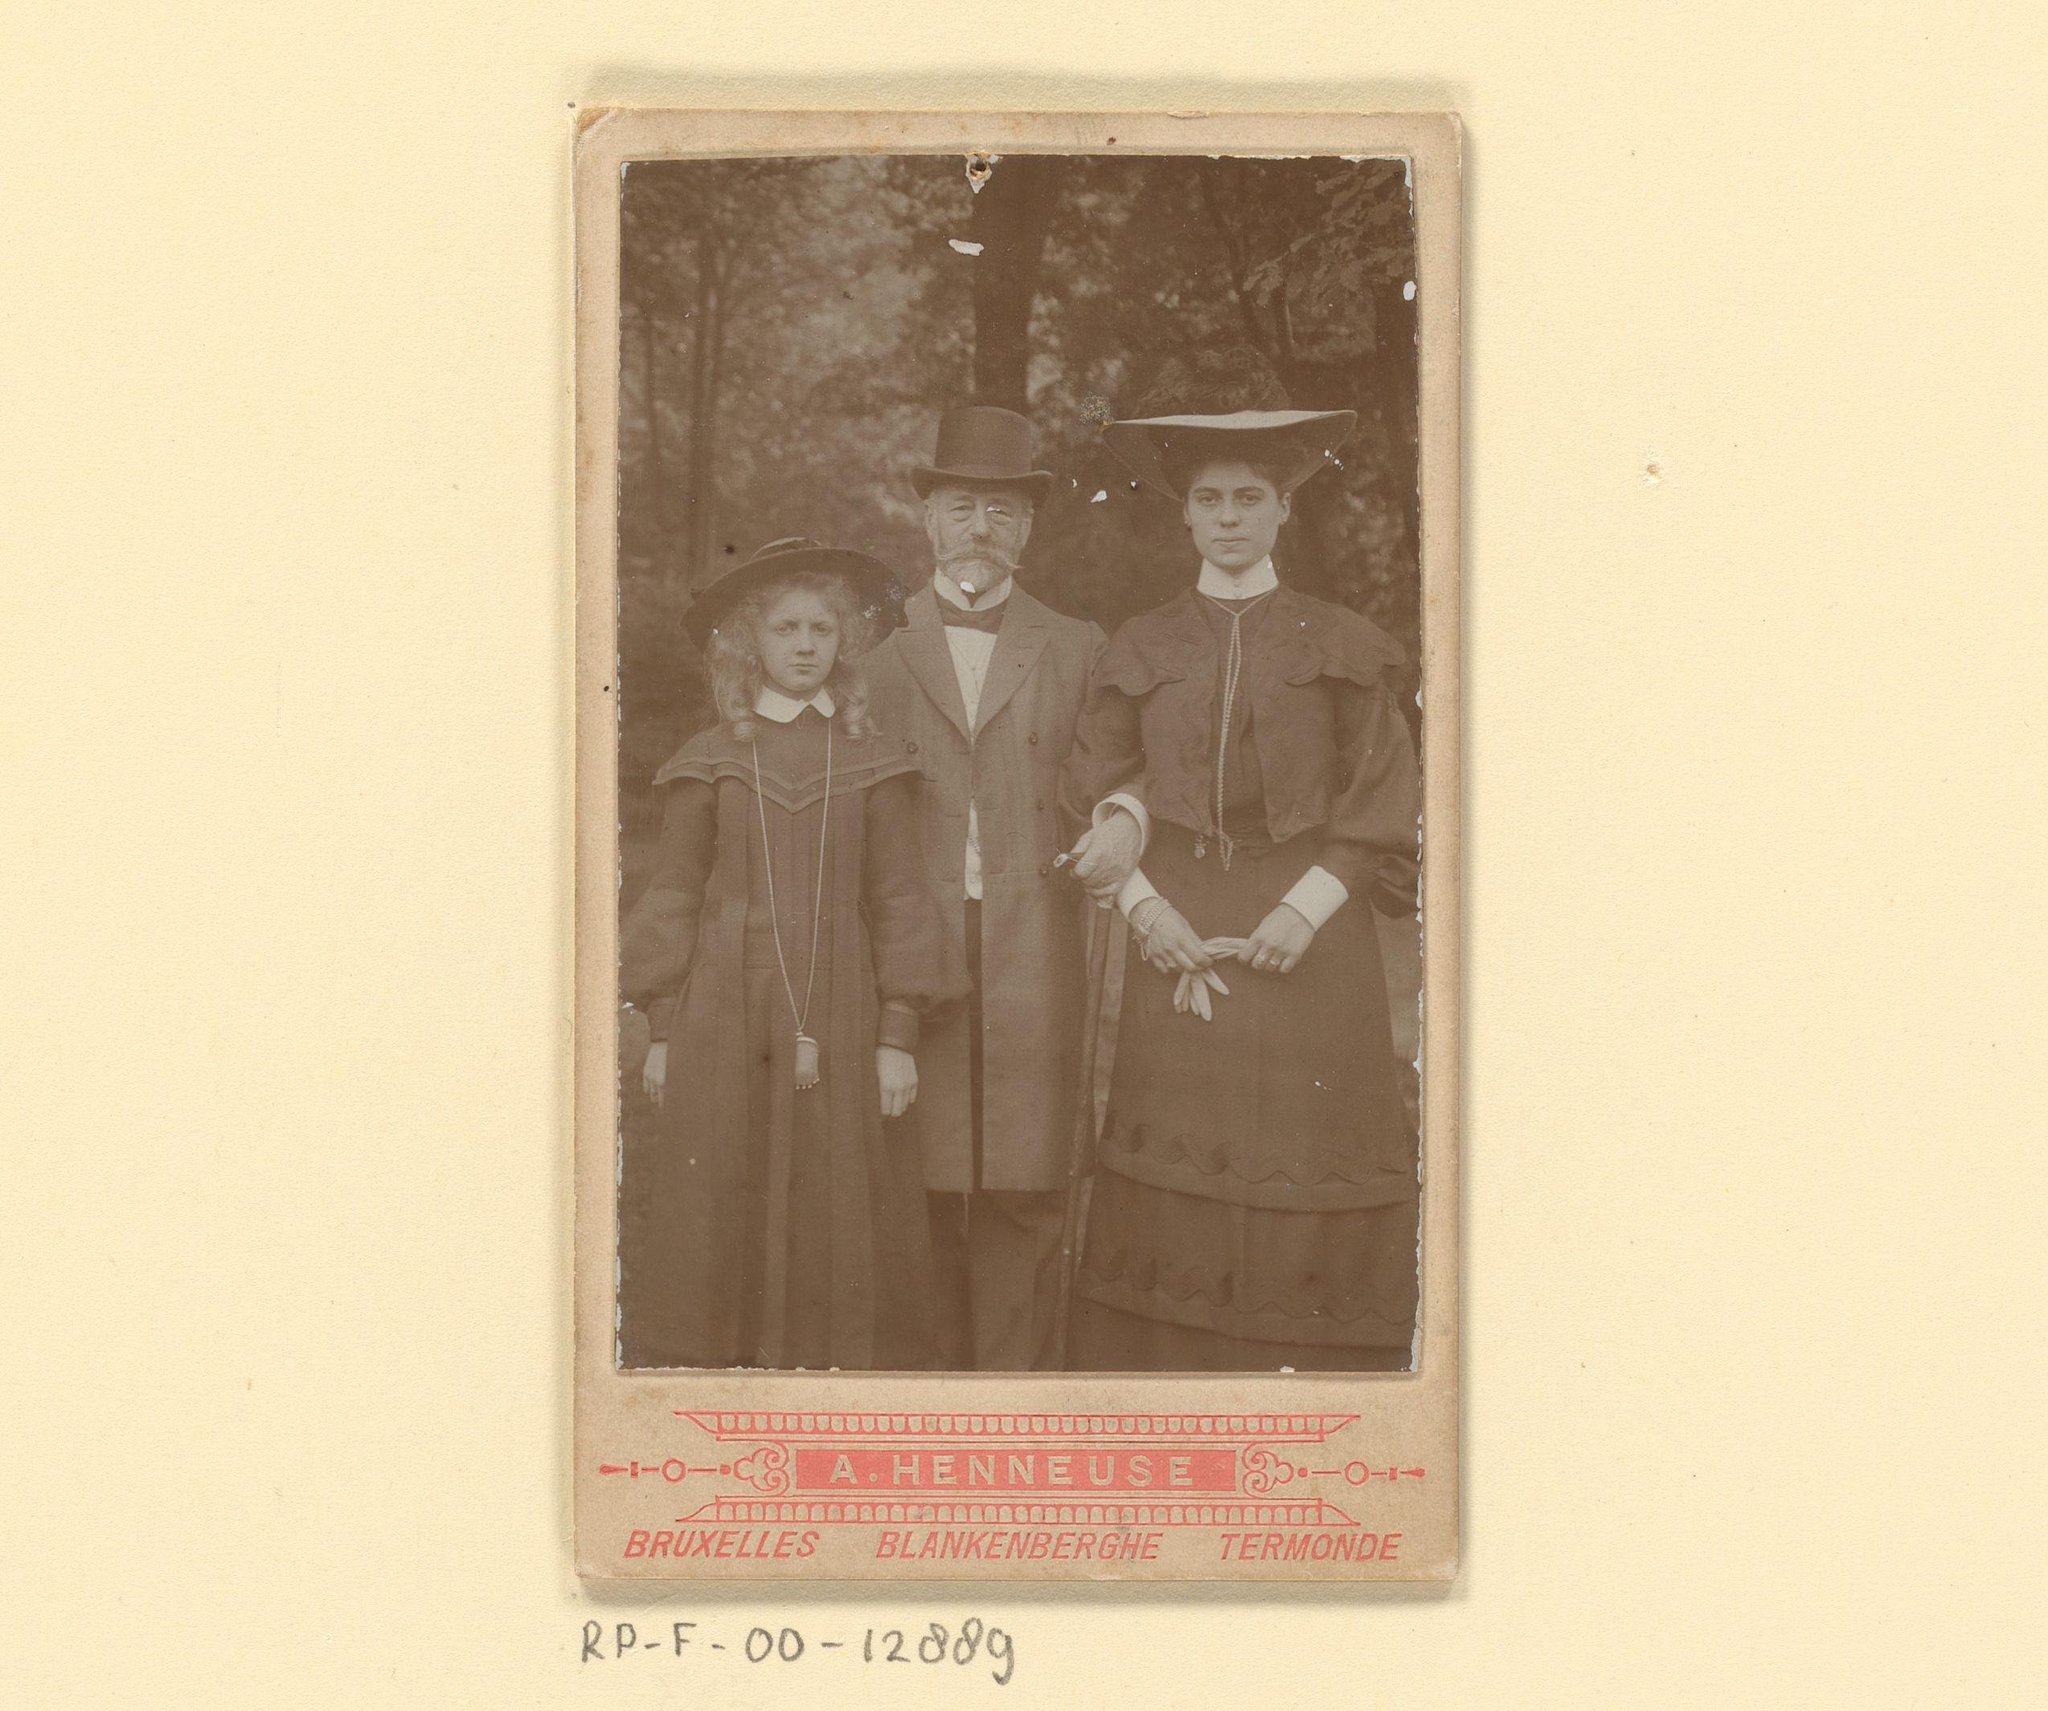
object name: photograph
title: Groepsportret van Isaac Gosschalk en zijn twee pleegkinderen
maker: a. henneuse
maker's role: fotograaf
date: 1899-1903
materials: paper, cardboard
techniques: collodion silver print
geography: belgium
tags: brussels, draughtsman, isaac gosschalk, portrait, self-portrait of artist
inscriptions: inscription: ‘Architect/ J. Gosschalk/ met zijn twee pleegkinderen’, inscription: ‘PHOTOGRAPHIE ARTISTIQUE/ A. HENNEUSE/ RUE D'ASSAT/ BRUXELLES/ SUCCURSALES/ 51, Rue de Bruxelles/ TERMONDE/ 15, Rue Vanderstichelen/ BLANKENBERGHE/ Les clichés sont conservés/ B.A. GRIMAUD PARIS’